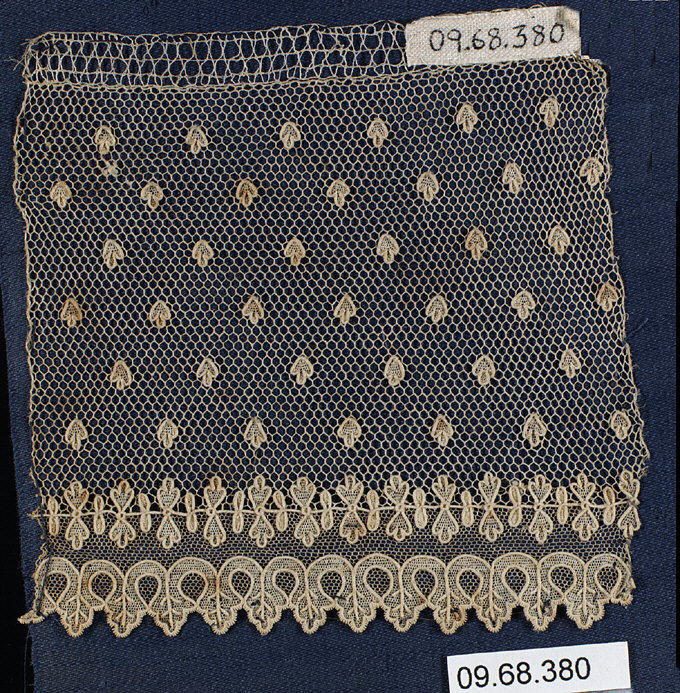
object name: fragment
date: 1801-1900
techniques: lace